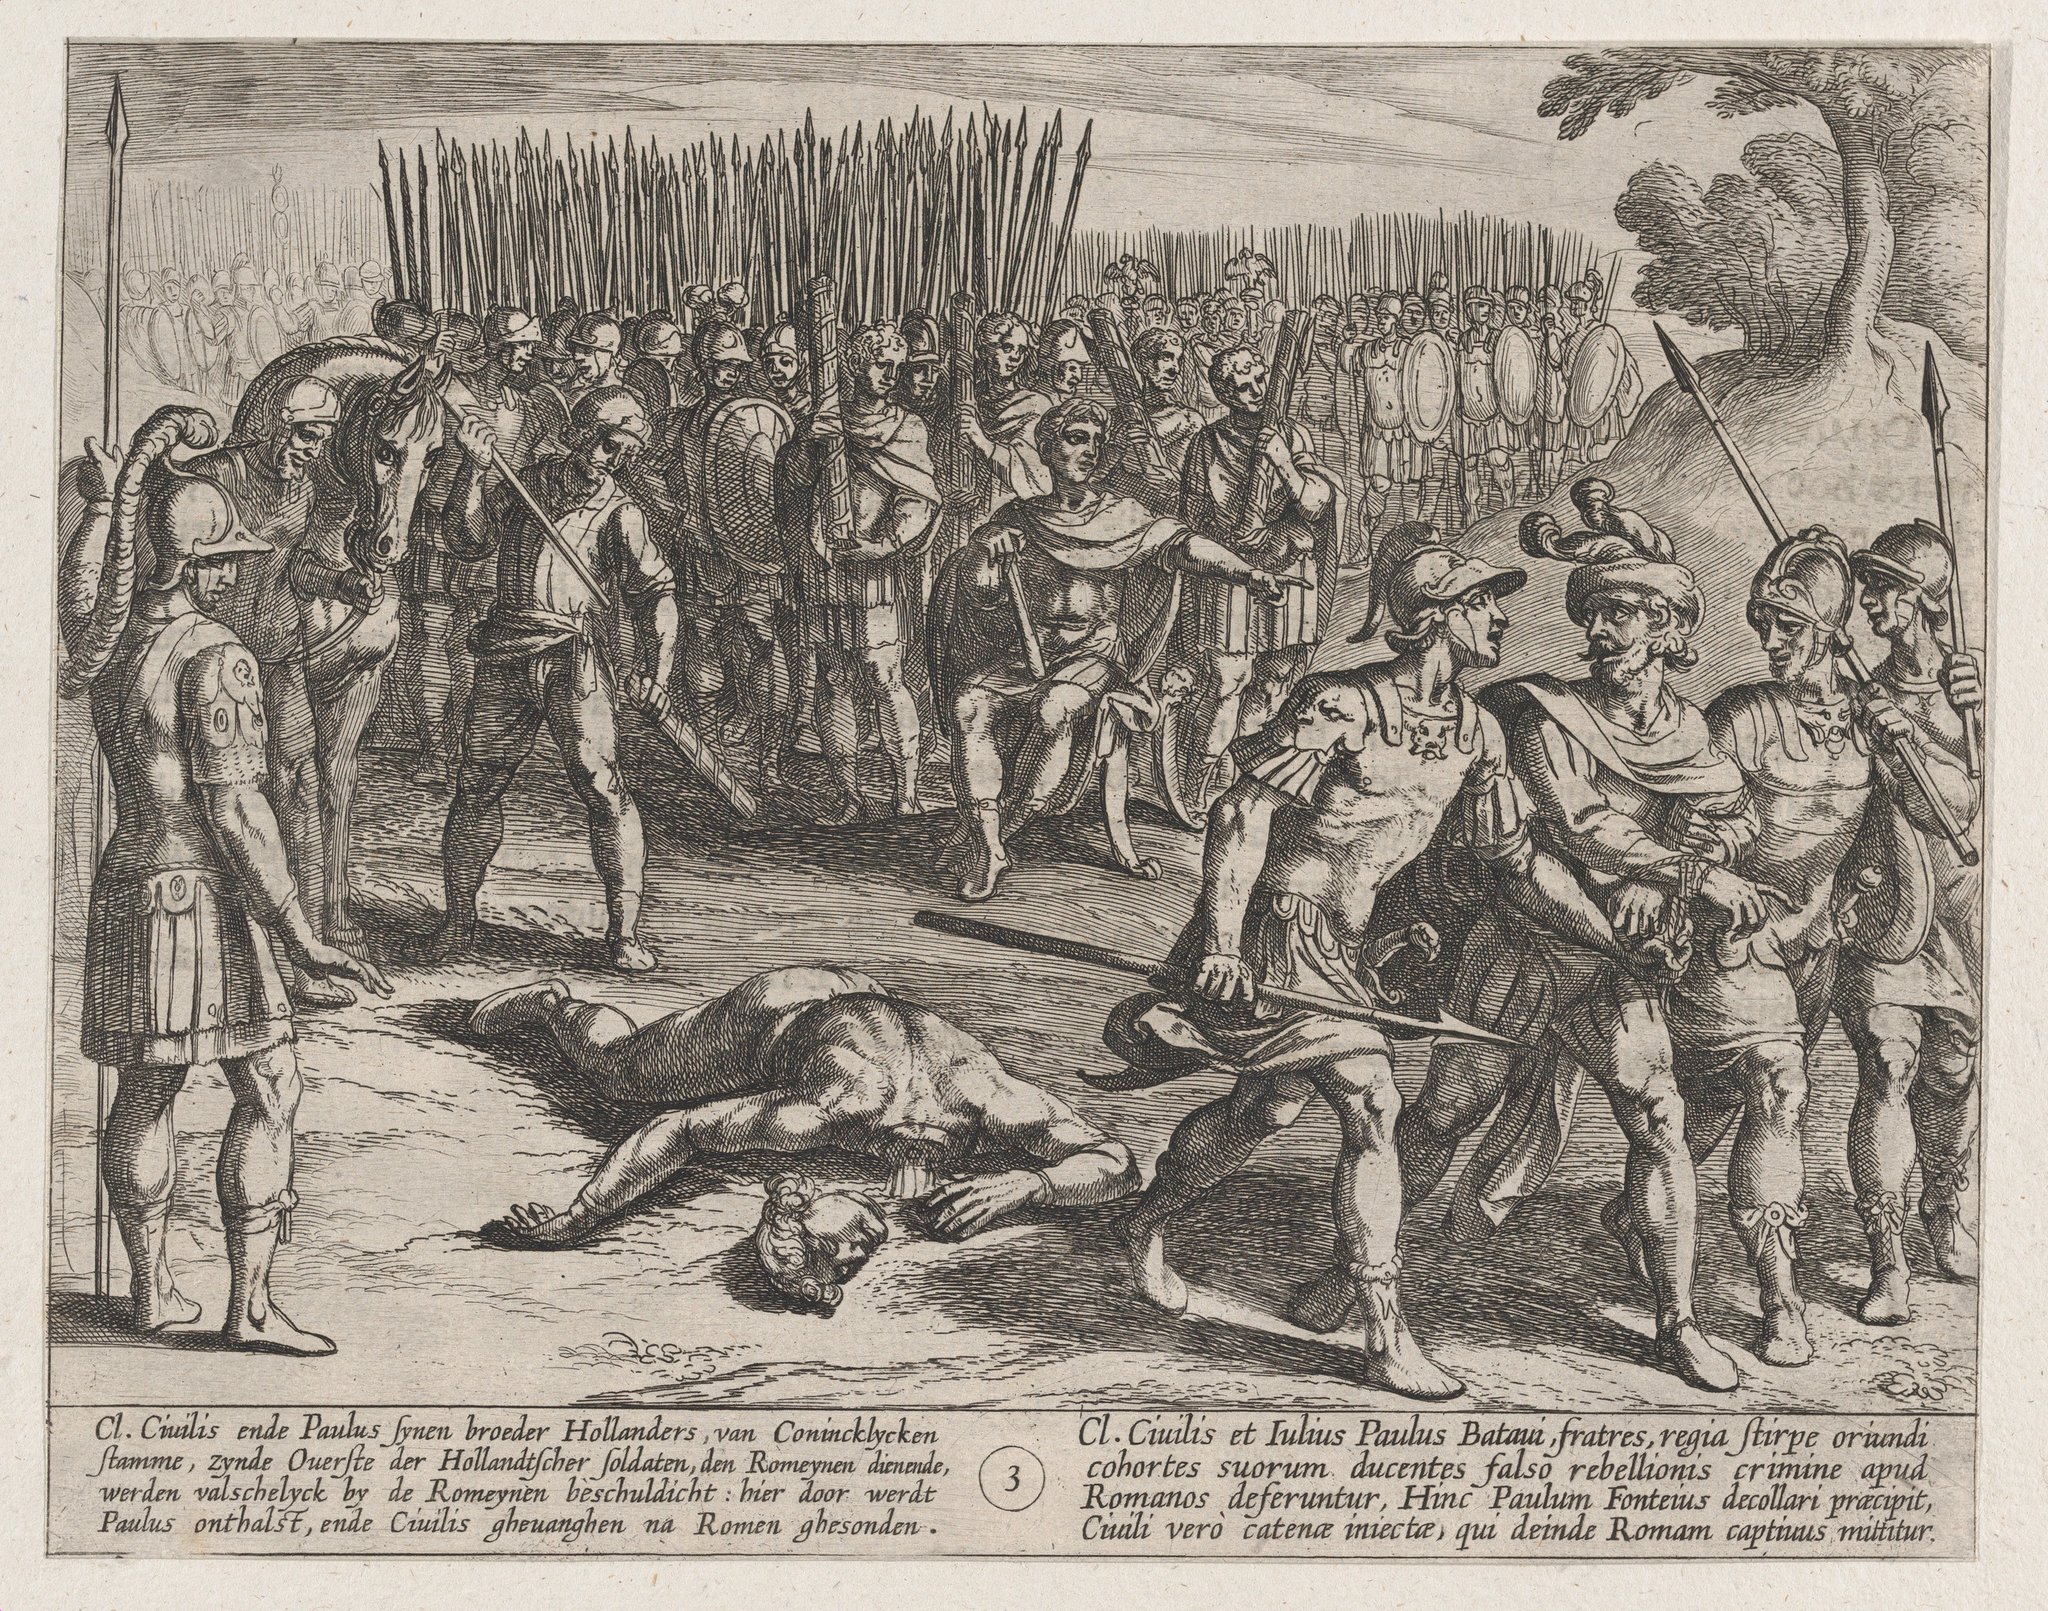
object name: print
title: Plate 3: Claudius Civilis Arrested and his Brother Paulus Beheaded, from The War of the Romans Against the Batavians (Romanorvm et Batavorvm societas)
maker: antonio tempesta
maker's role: artist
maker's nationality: italian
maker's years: 1555-1630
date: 1611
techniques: etching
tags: wars,army,men,execution